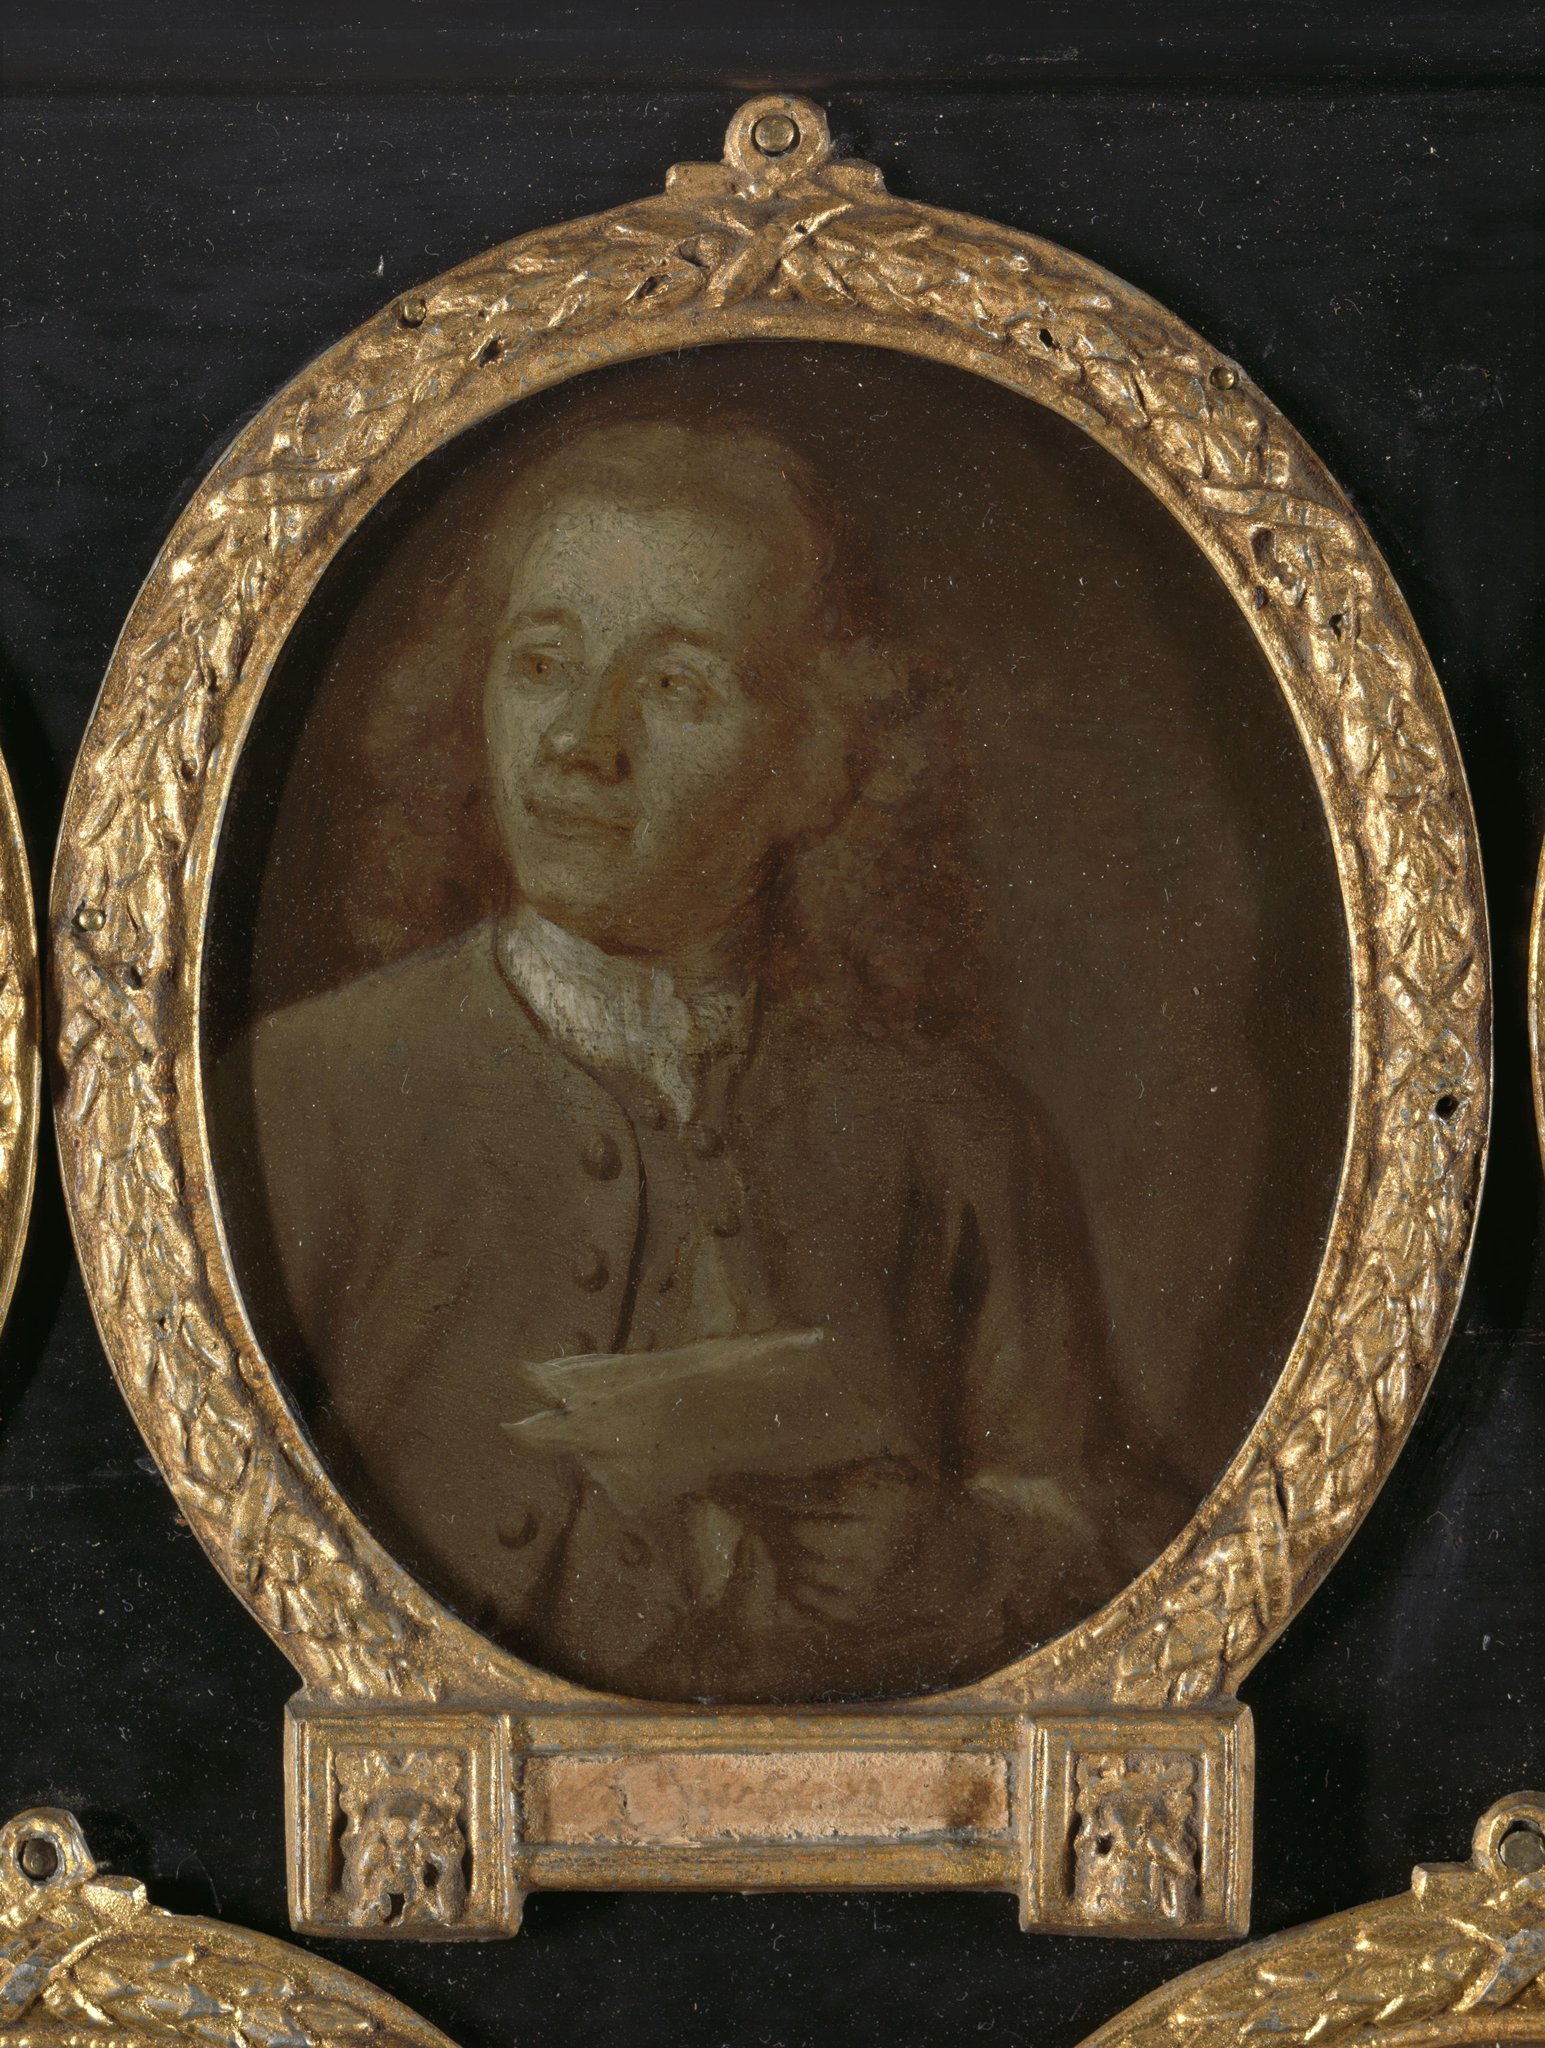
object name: grisaille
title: Portrait of Abraham Haen the Younger, Draftsman, Etcher and Poet in Amsterdam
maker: jan maurits quinkhard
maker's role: draughtsman, painter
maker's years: 1688-1772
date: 1732-1771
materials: oil, metal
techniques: grisaille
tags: portrait of a writer, portrait, self-portrait of artist, writer, poet, author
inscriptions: inscription: ‘Ab.m de Haen’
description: Portret van Abraham de Haen (1707-48). Tekenaar, etser en dichter te Amsterdam. Buste in ovaal, het hoofd naar links gekeerd. In de linkerhand een gevouwen blad papier. Misschien naar een prent van C.F. Fritzsch. Onderdeel van een verzameling portretten van Nederlandse dichters.